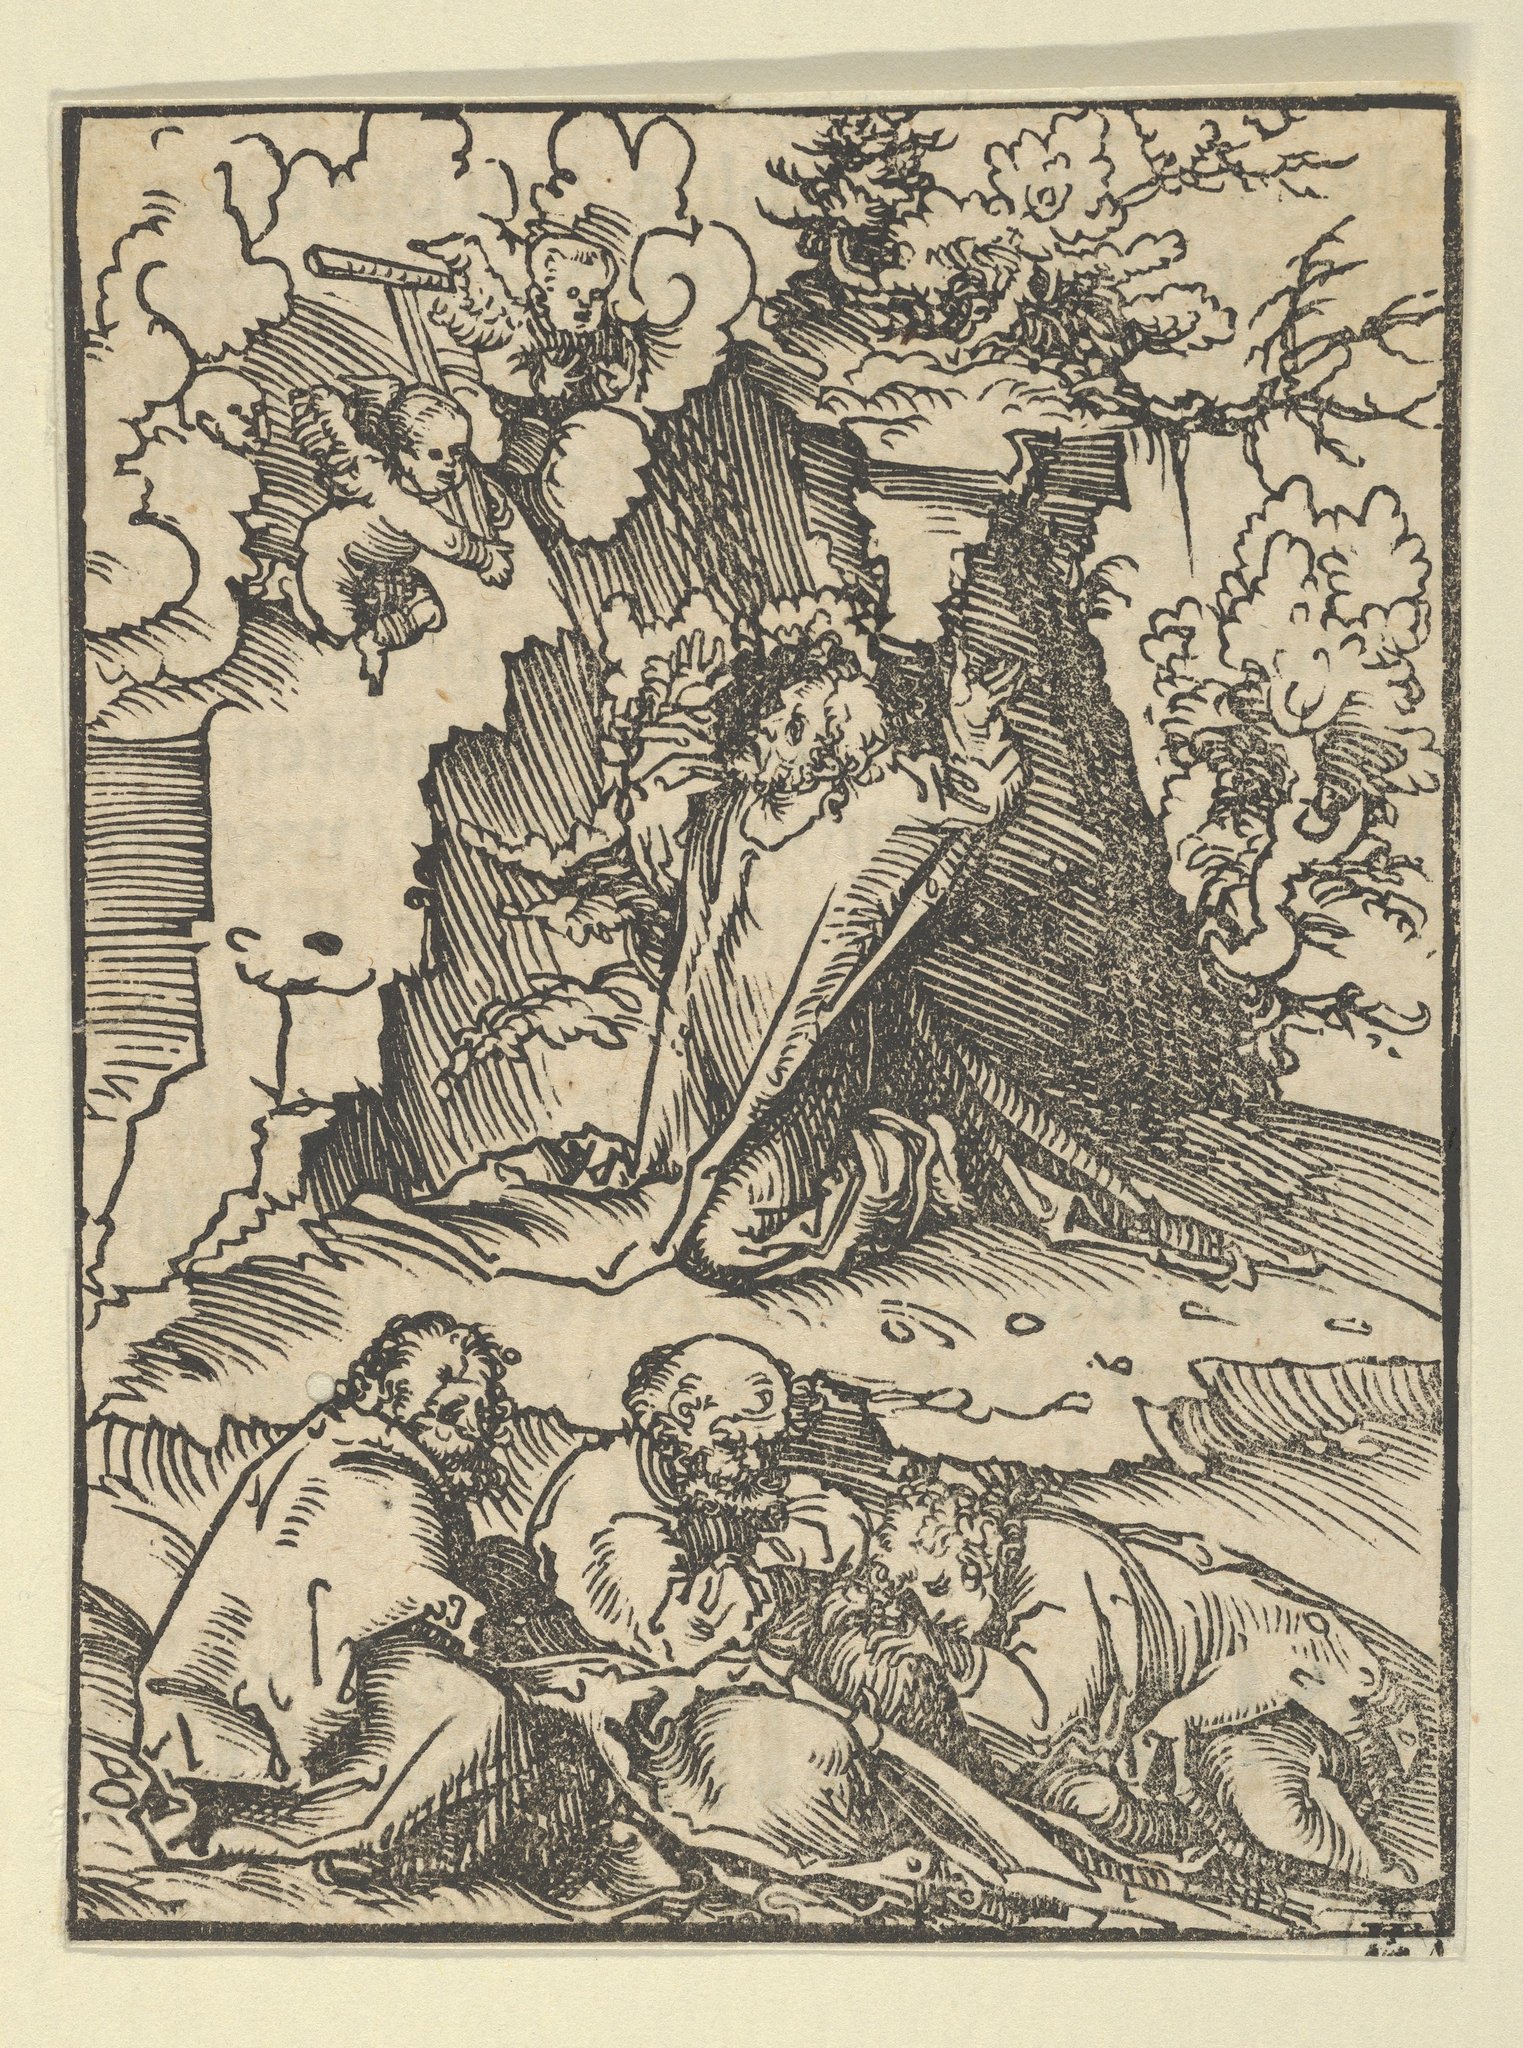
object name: print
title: Relief with Christ on the Mount of Olives, from the "Wittenberg Reliquaries"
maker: lucas cranach the elder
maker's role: artist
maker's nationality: german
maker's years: 1472-1553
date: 1472-1553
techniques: woodcut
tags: men,angels,christ